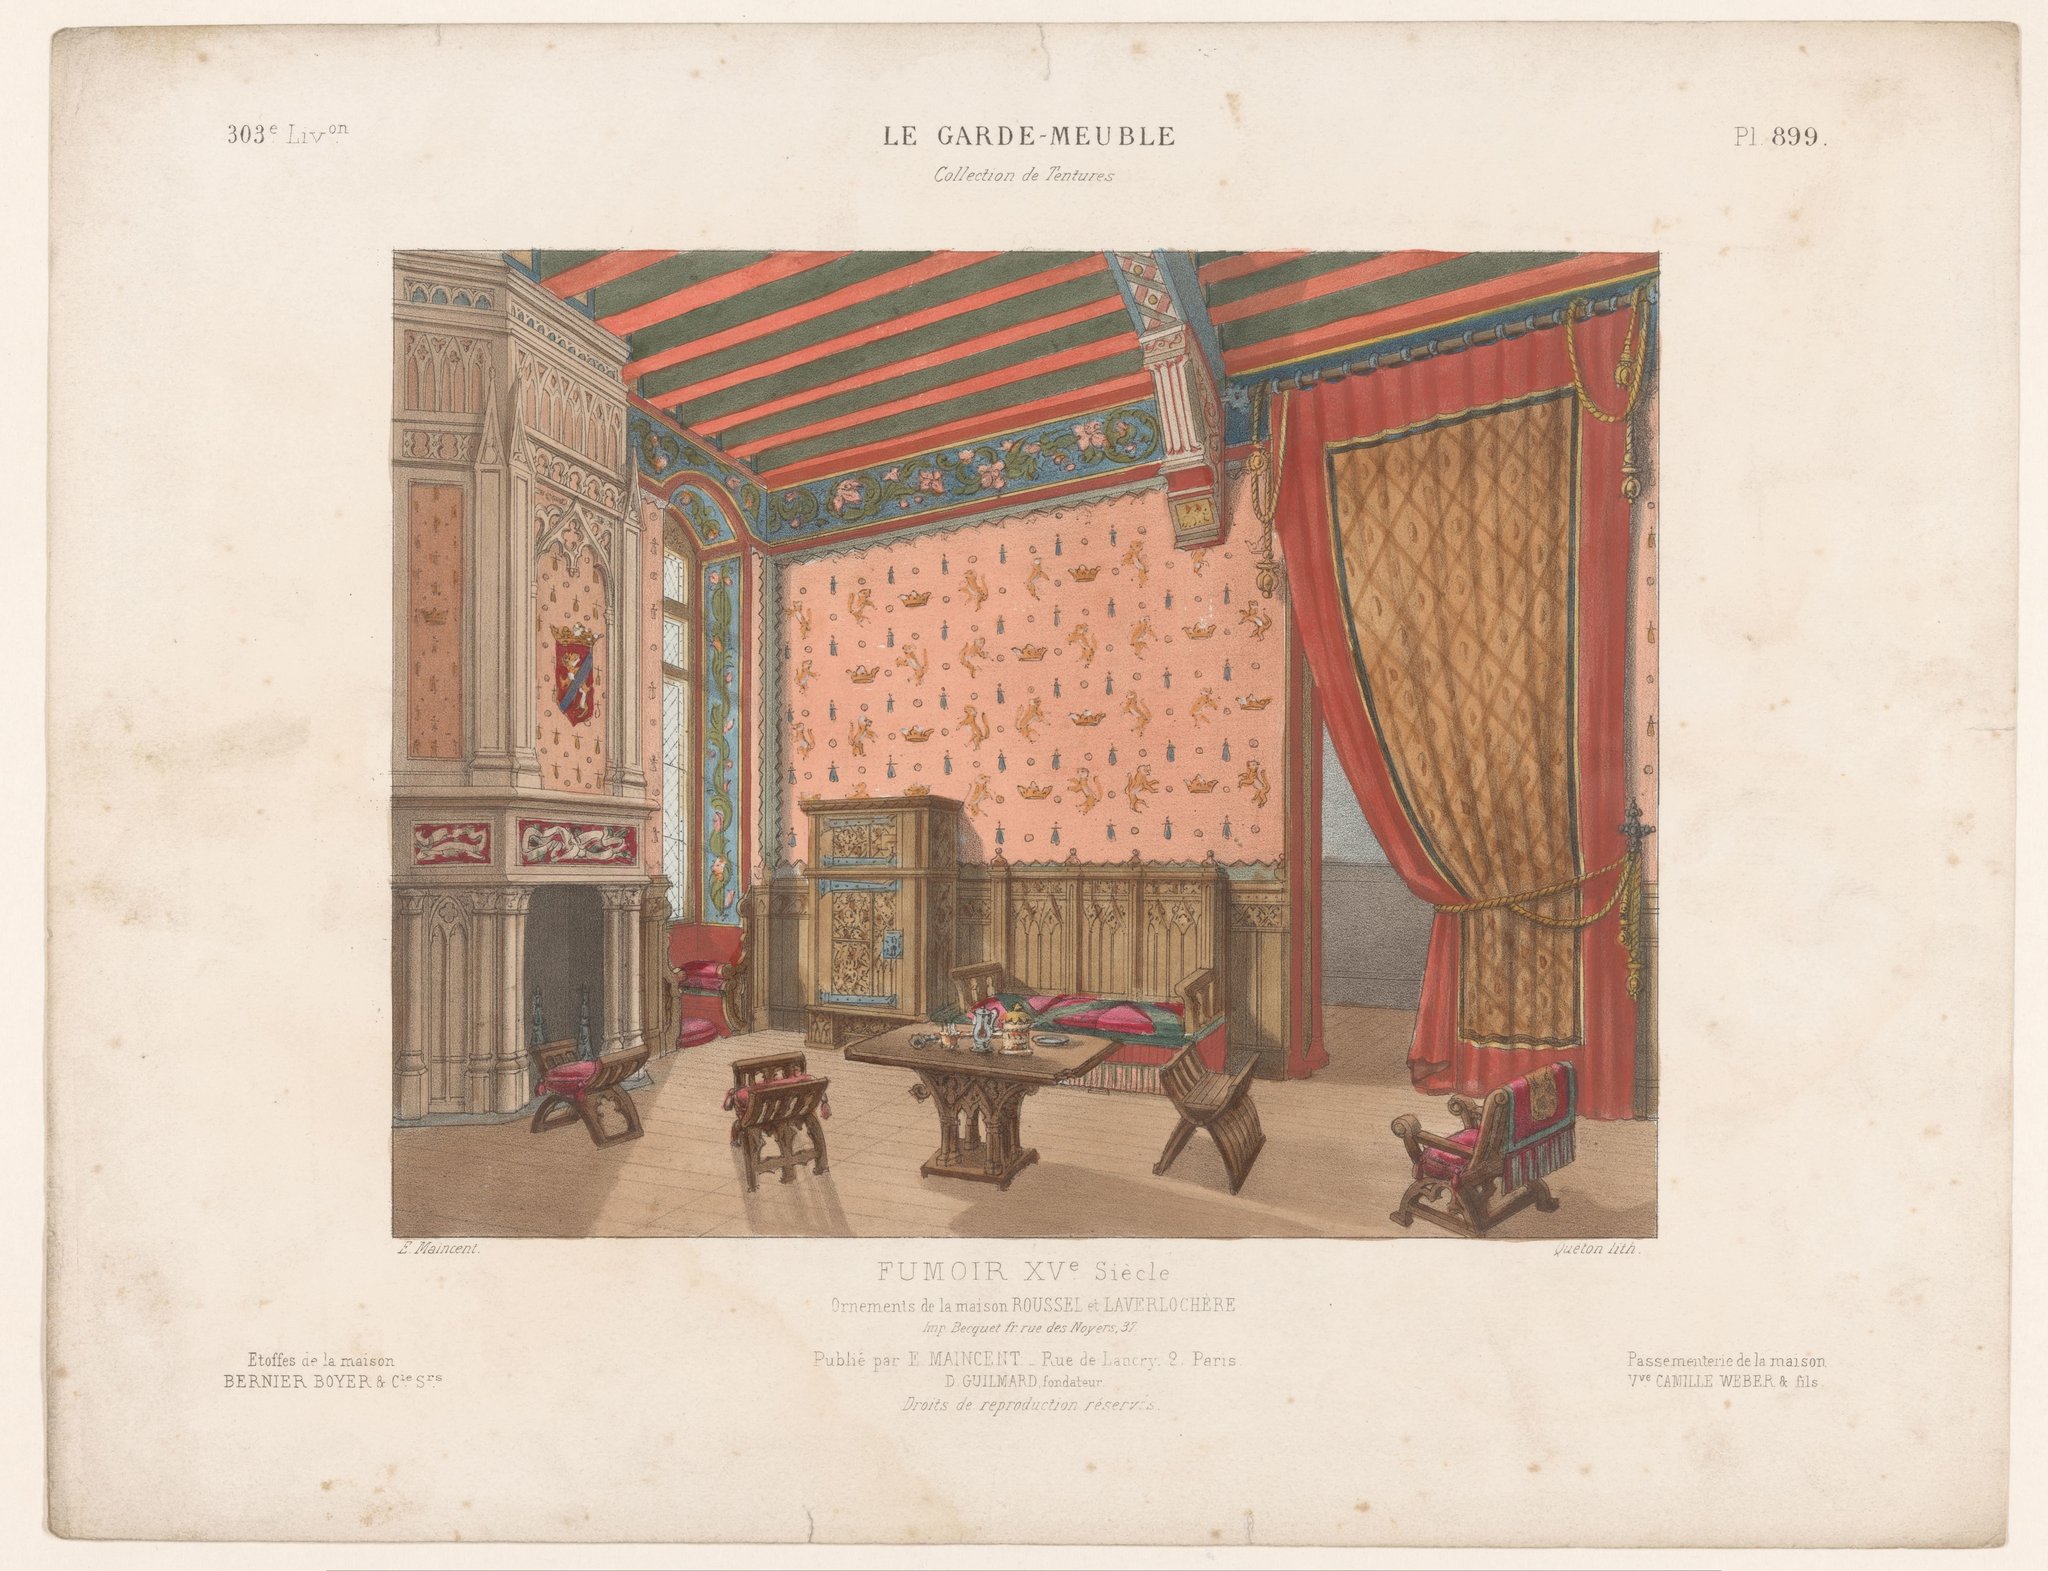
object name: print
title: Le Garde-Meuble / Collection de Tentures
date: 1885-1895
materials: paper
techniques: hand coloring, lithograph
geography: paris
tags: decorations (interior of the house), hangings and drapery, other rooms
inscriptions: : ‘Droits de reproduction réservés.’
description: Rooksalon met gedrapeerd gordijn in vijftiende-eeuwse stijl. Prent uit 303e Livraison.